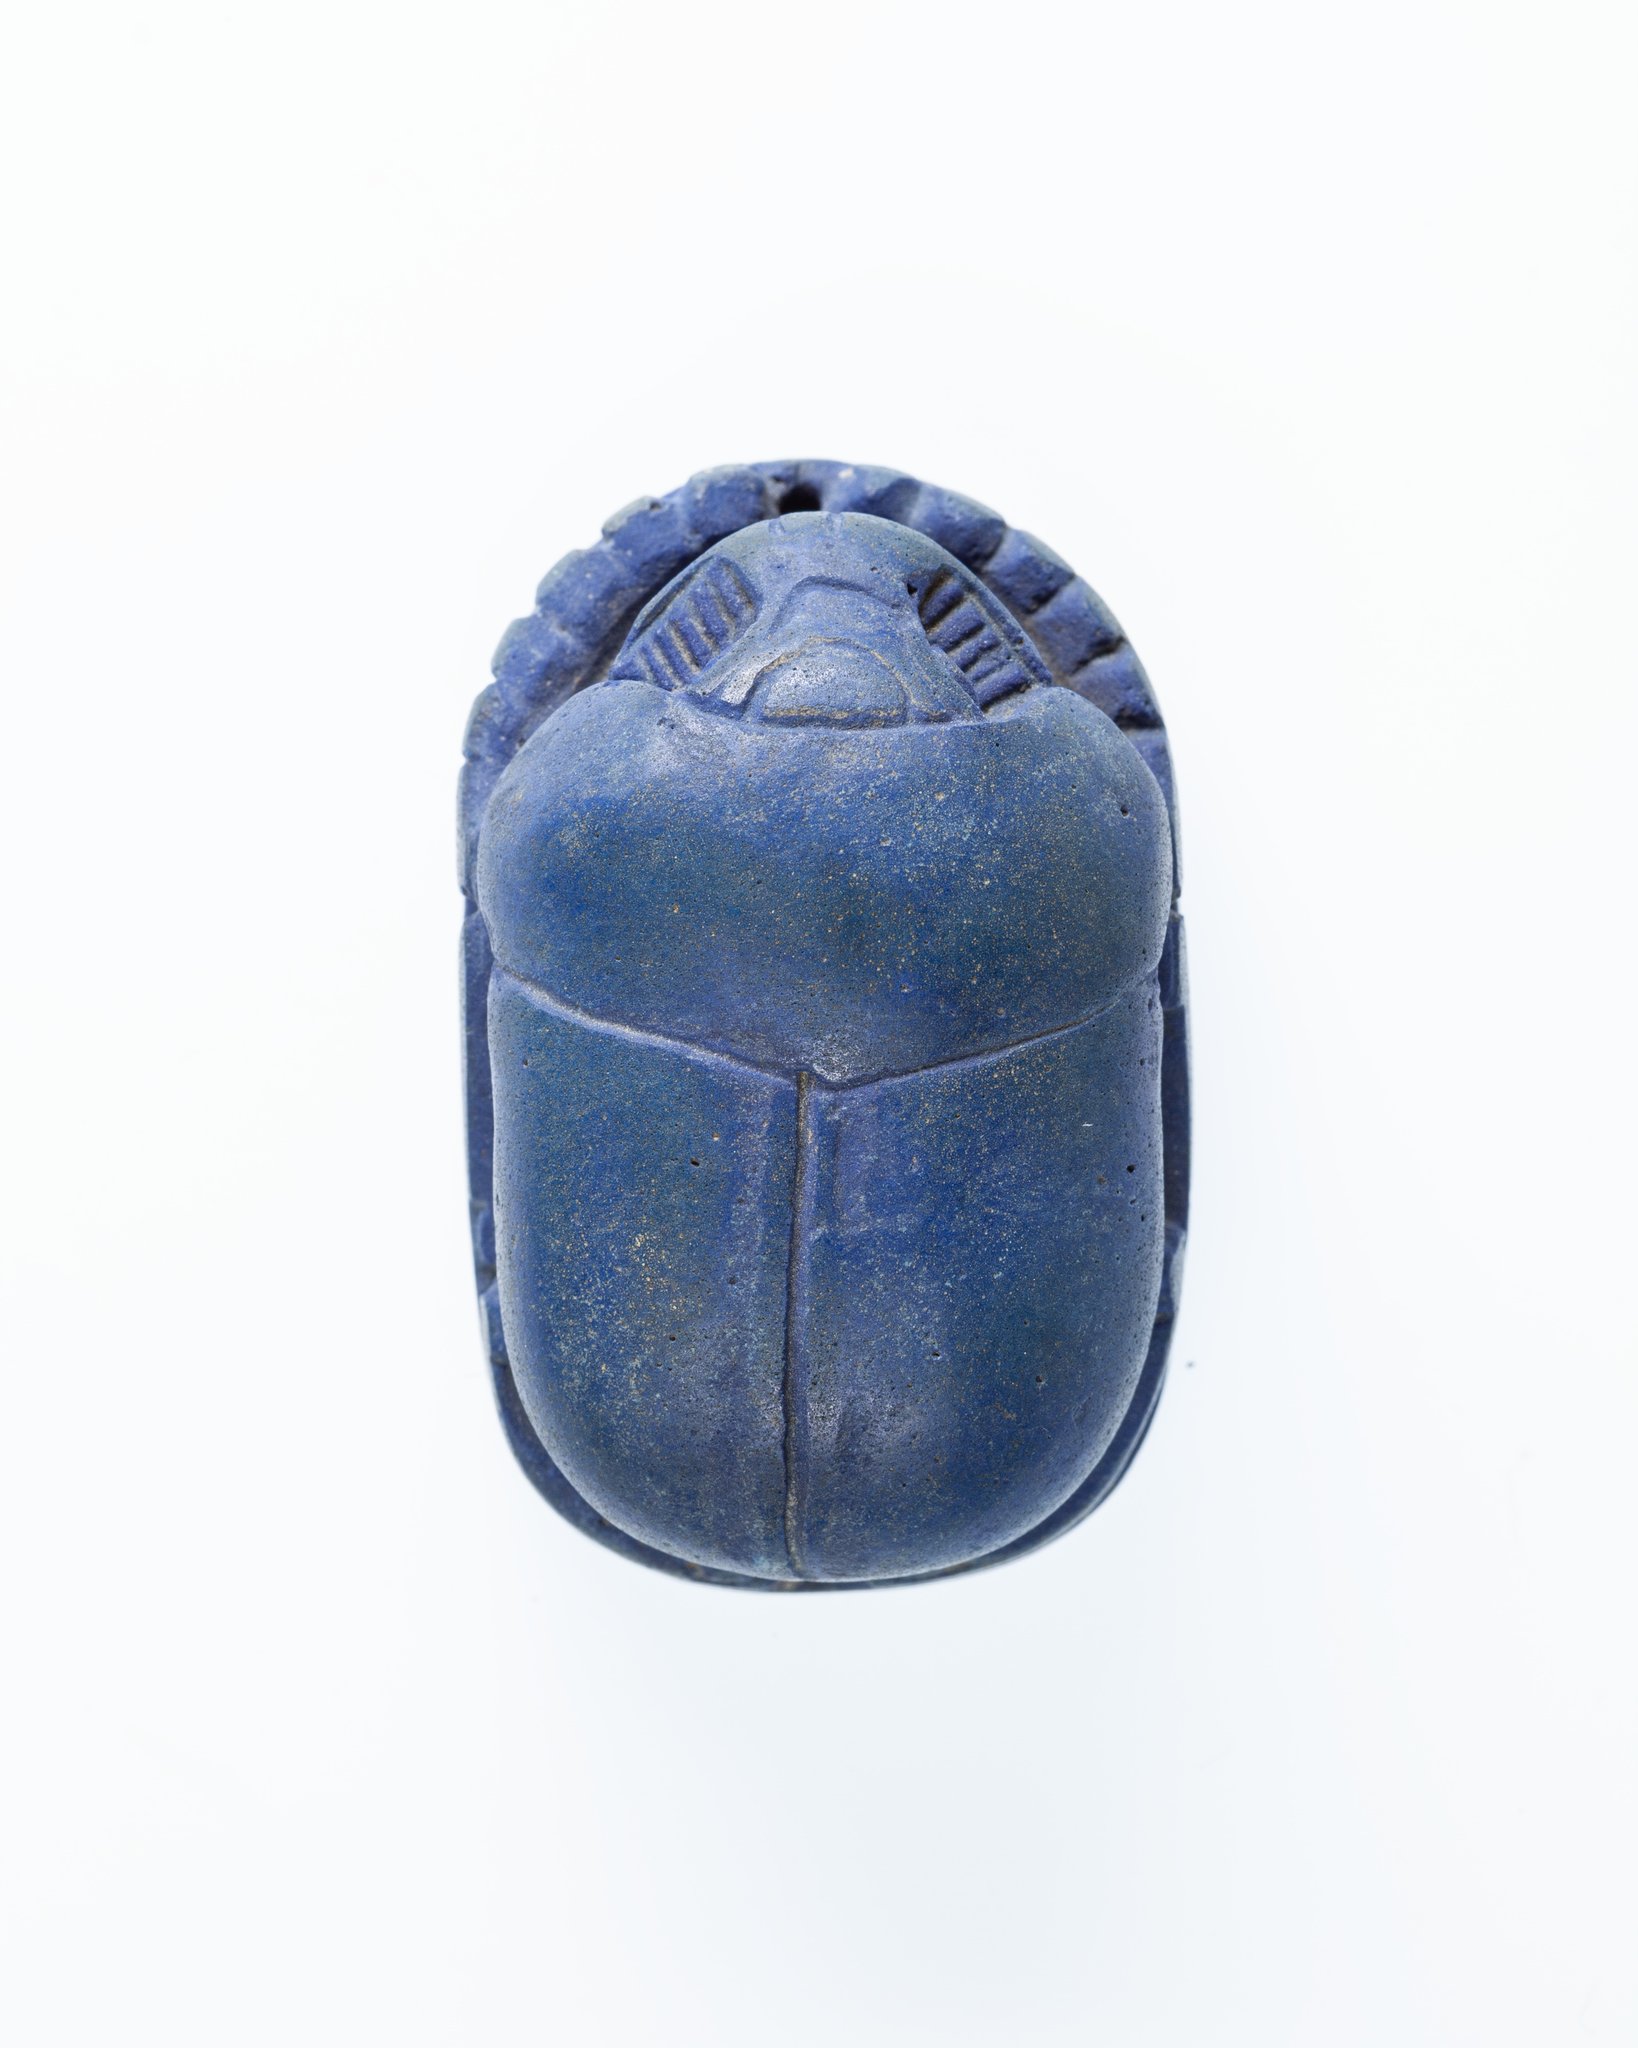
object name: heart scarab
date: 1070-664 BCE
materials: paste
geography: egypt